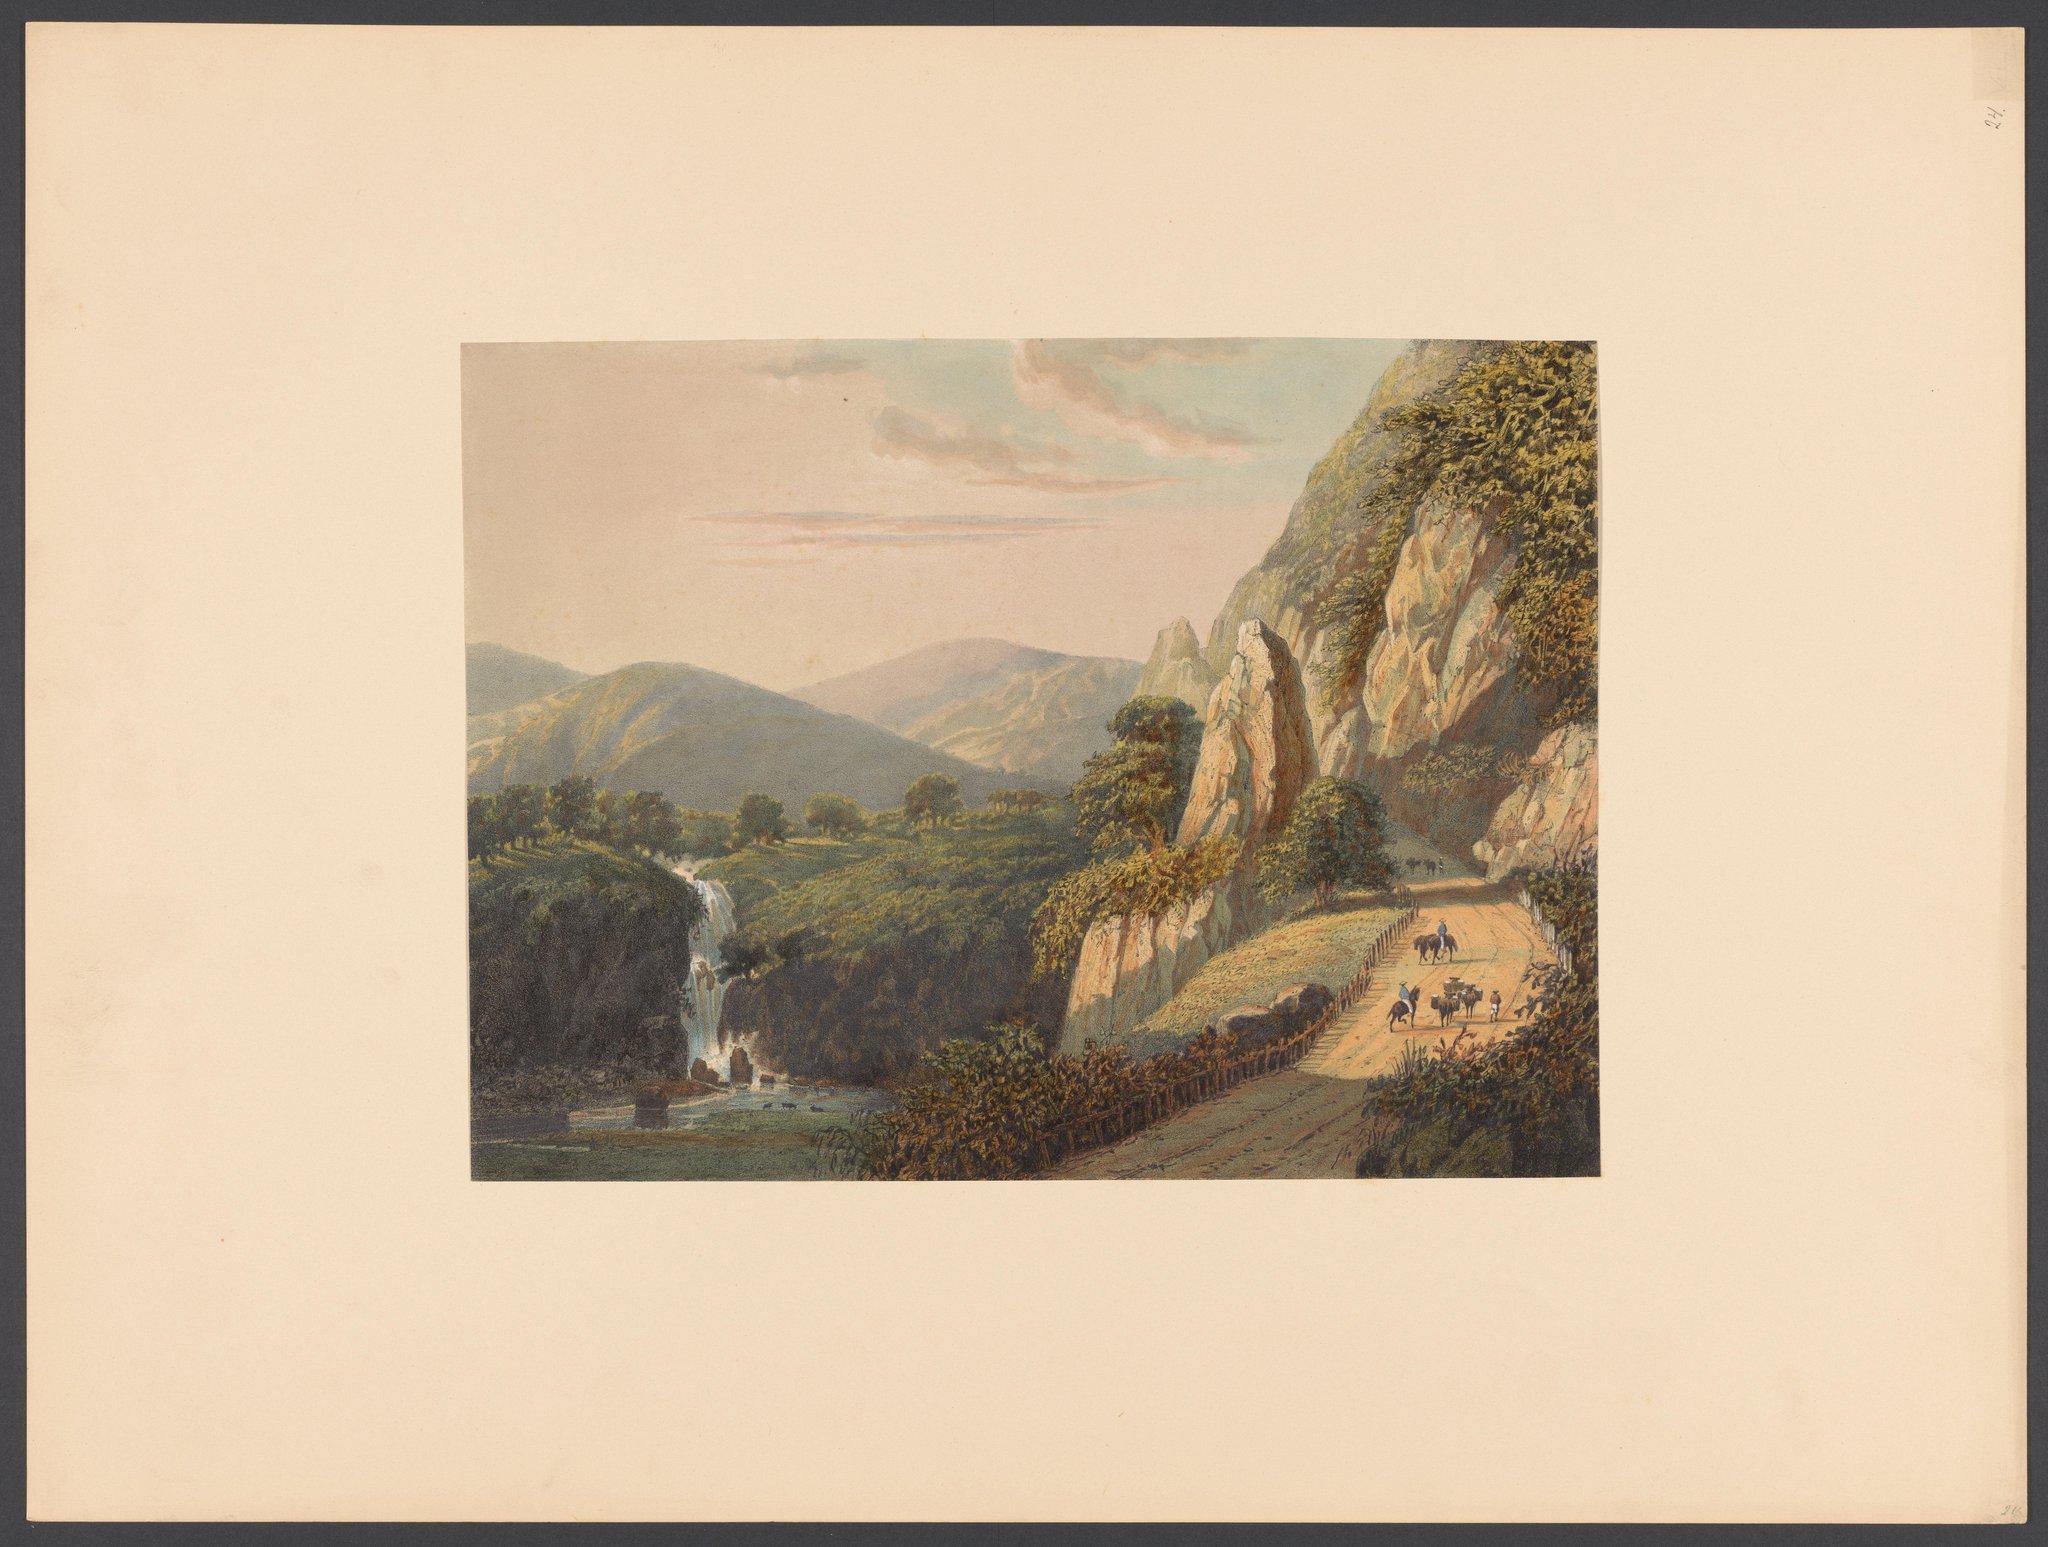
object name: print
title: In het Sumedangsche; Preanger Regentschappen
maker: johan conrad greive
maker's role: draughtsman, painter, print maker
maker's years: 1837-1891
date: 1865-1872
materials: paper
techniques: lithograph, hand coloring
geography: amsterdam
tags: riding a horse, ass, or mule; rider, horseman, waterfall, landscapes (+ landscape with figures, staffage), mountains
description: Volgens de bijbehorende inhoudsopgave betreft dit de 24ste prent uit de reeks van 24.